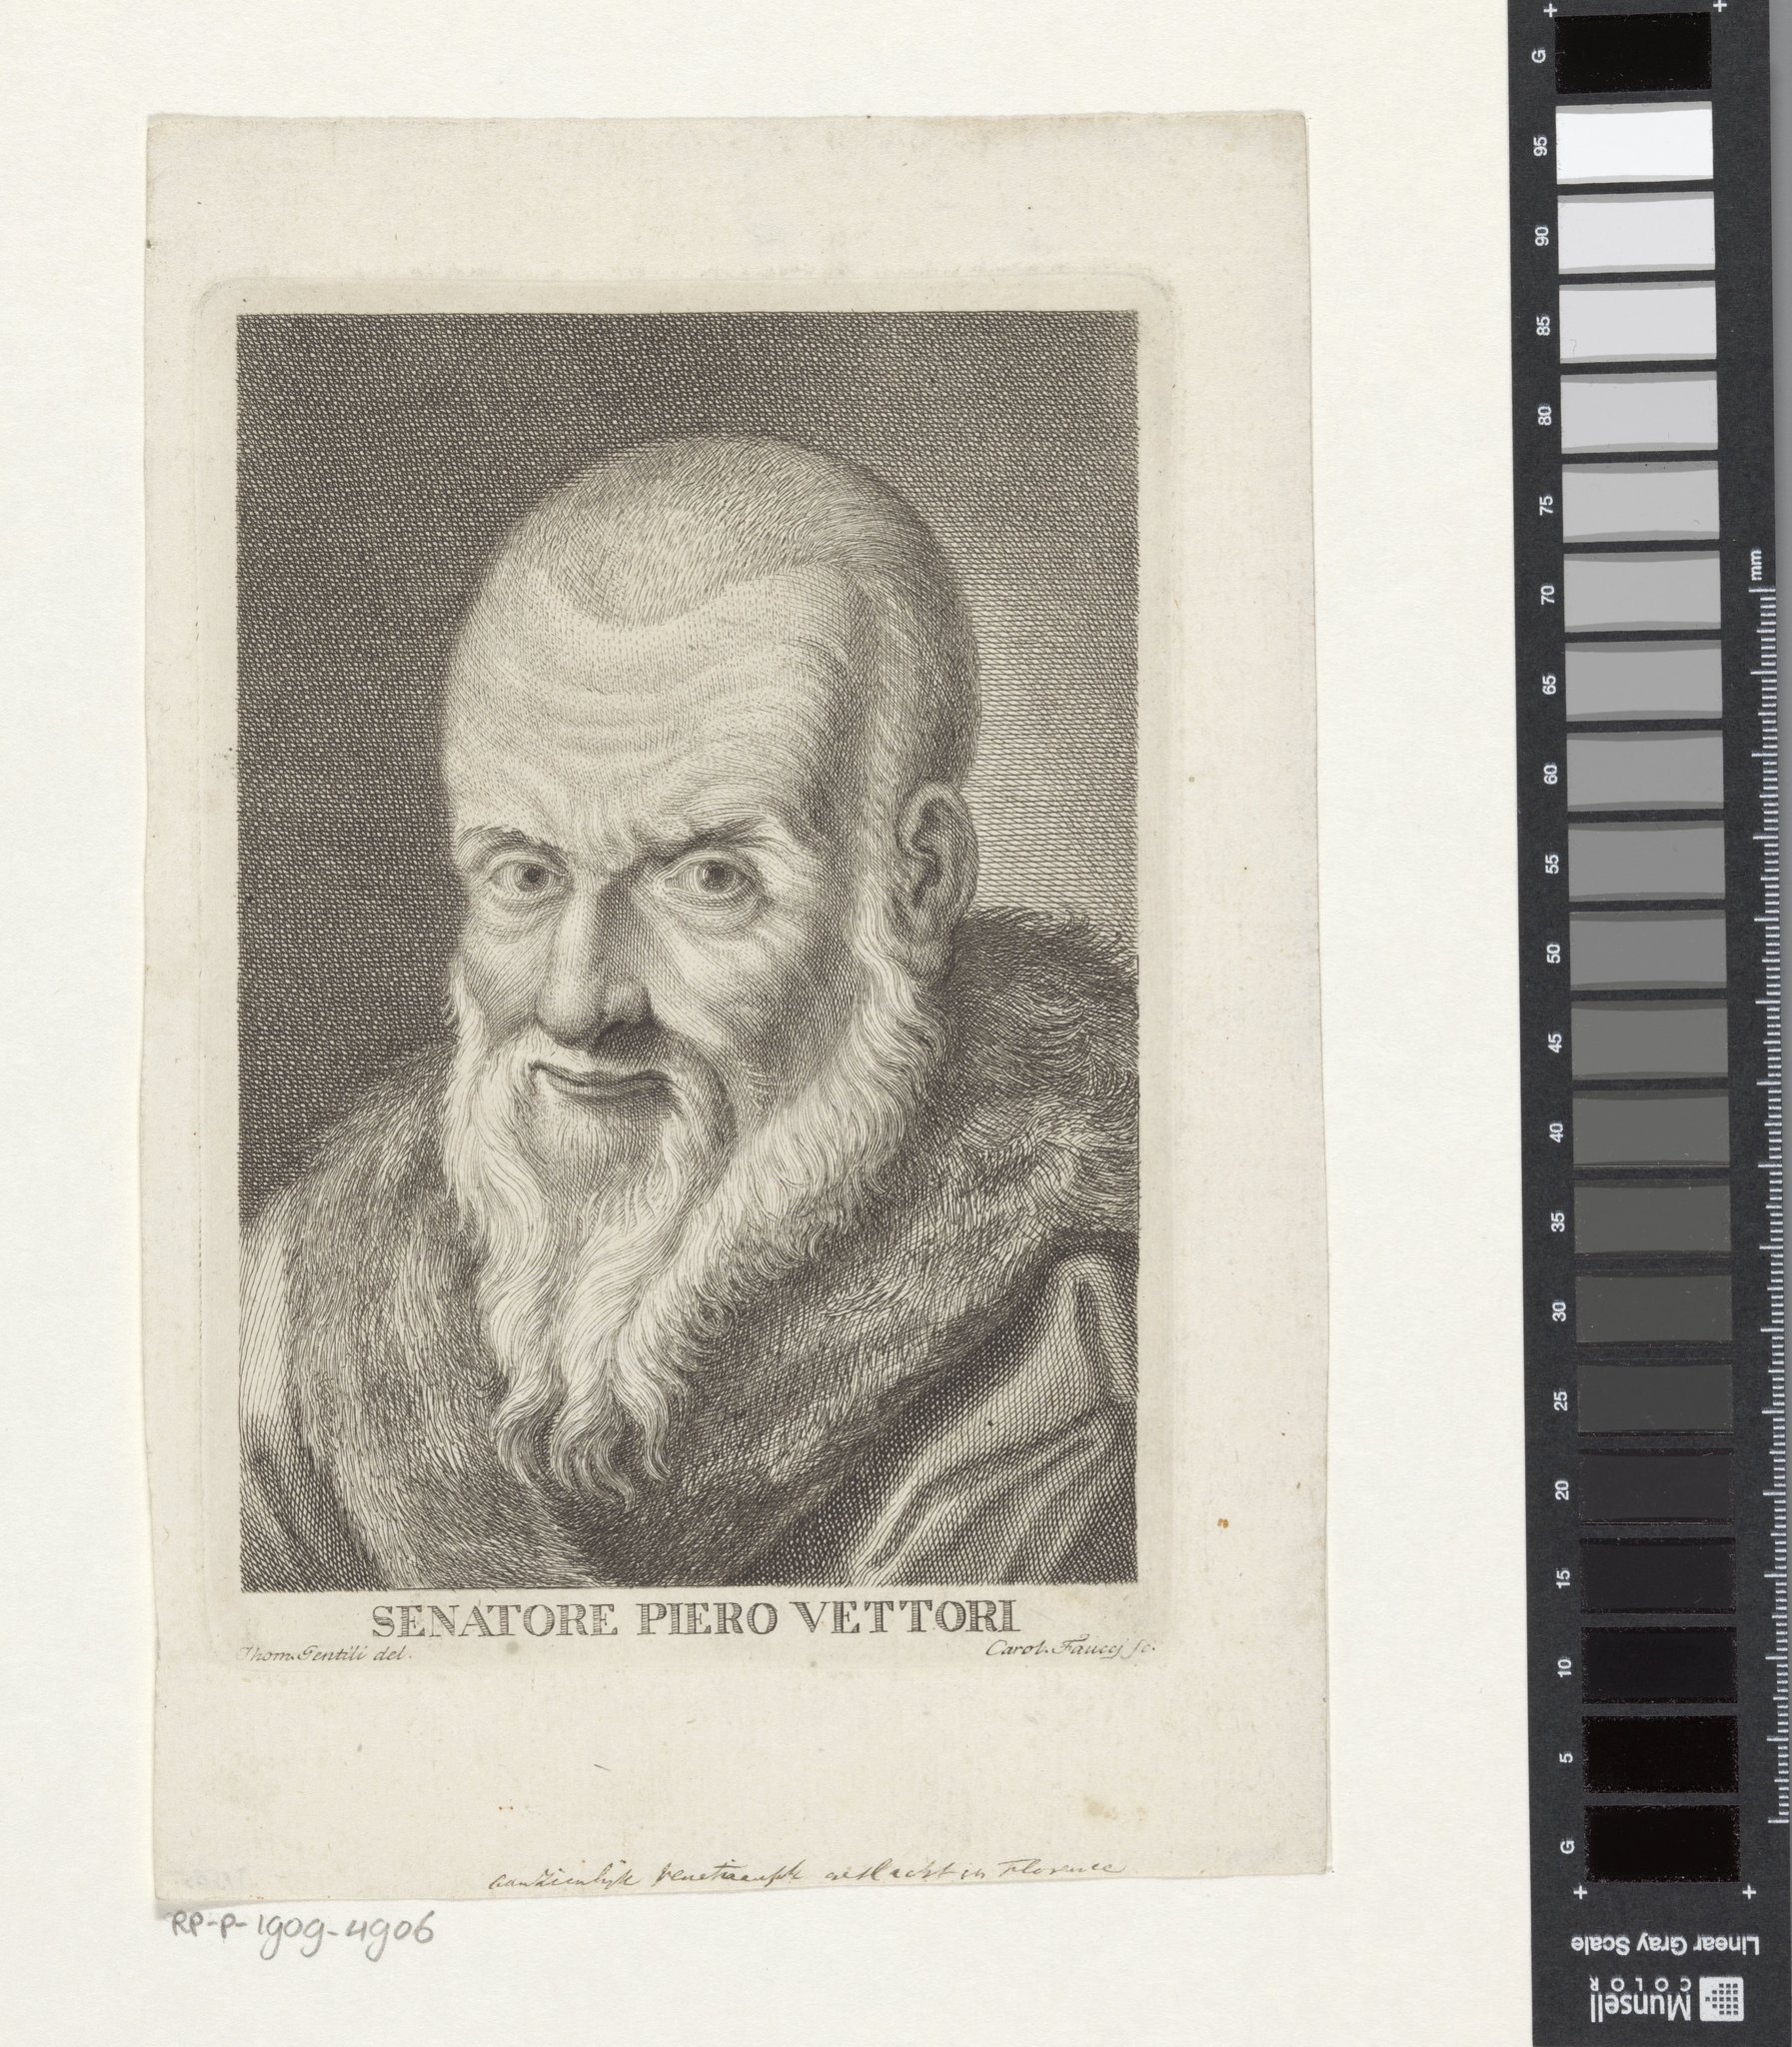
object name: print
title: Portret van Piero Vettori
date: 1739-1784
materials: paper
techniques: engraving, etching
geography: italy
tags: historical persons, portrait of a writer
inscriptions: inscription: ‘Aanzienlijk Venetiaansch geslacht in Florence’, collector's mark: Lugt 2228